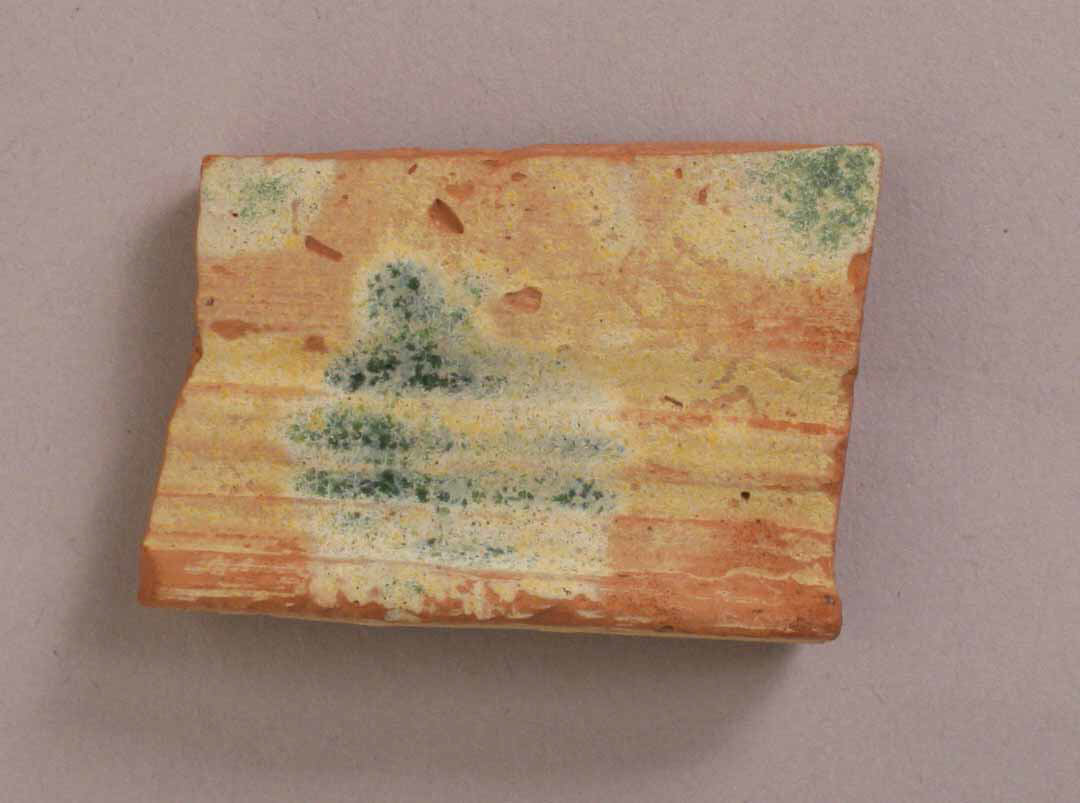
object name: fragment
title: Ceramic Fragment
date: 801-900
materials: earthenware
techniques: glazing, painting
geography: saudi arabia